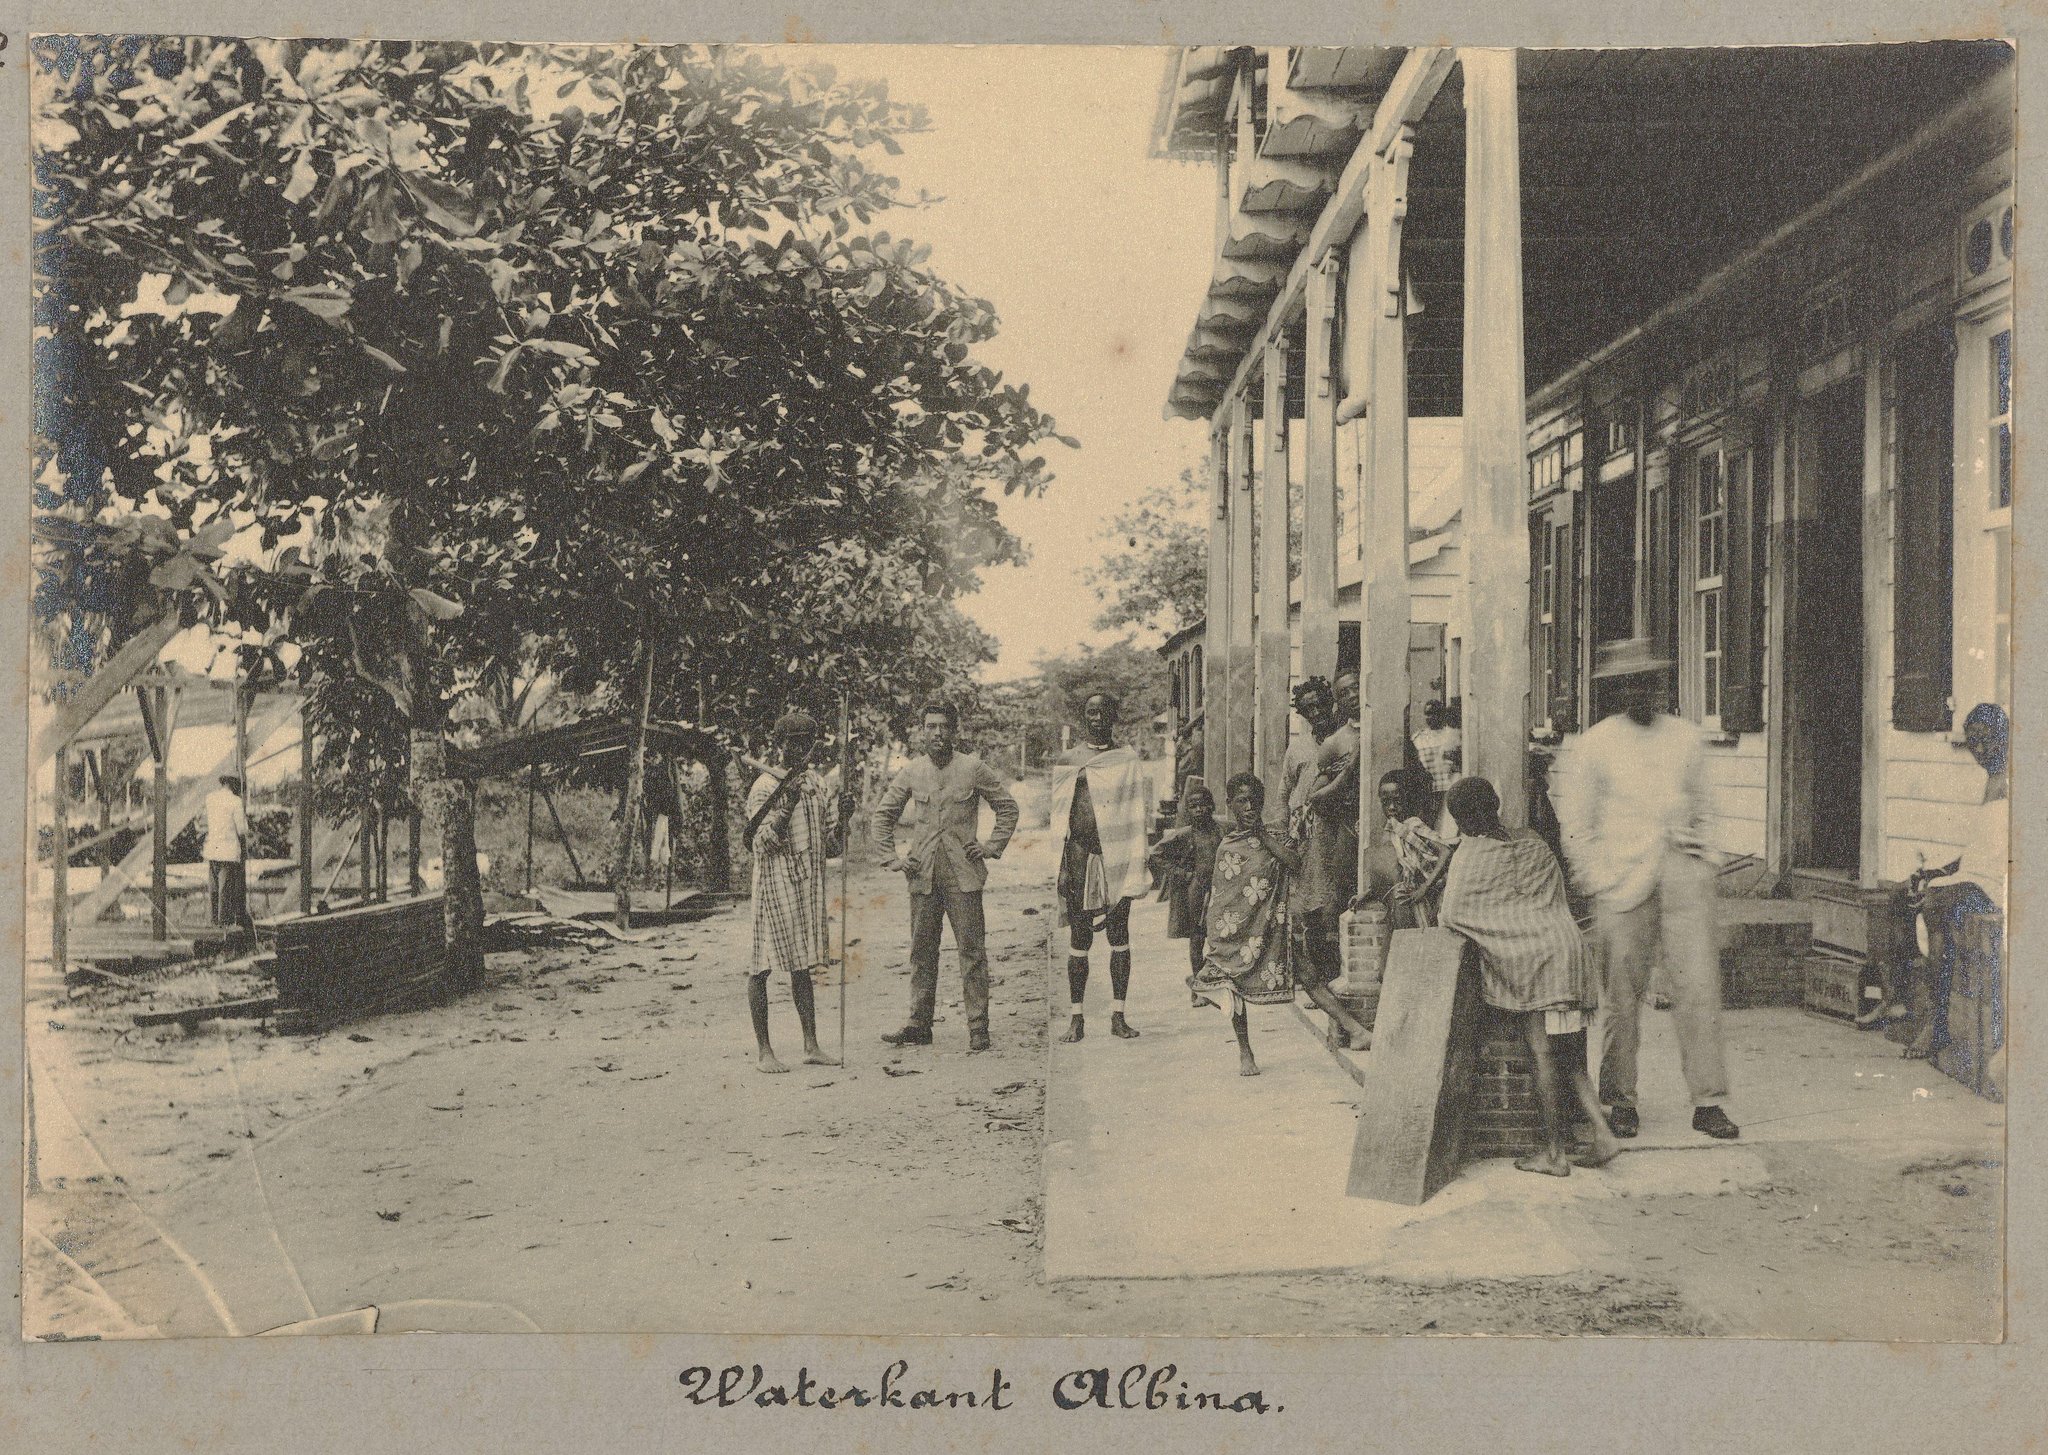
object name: photograph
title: Waterkant Albina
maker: gomez burke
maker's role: fotograaf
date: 1891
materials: photographic support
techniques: gelatin silver print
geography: suriname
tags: suriname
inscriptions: inscription: ‘G.B. / Waterkant Albina.’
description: Gezicht aan de Waterkant te Albina, op straat en voor een huis staan verschillende personen. Onderdeel van het fotoalbum Souvenir de Voyage (deel 4), over het leven van de familie Dooyer in en rond de plantage Ma Retraite in Suriname in de jaren 1906-1913.